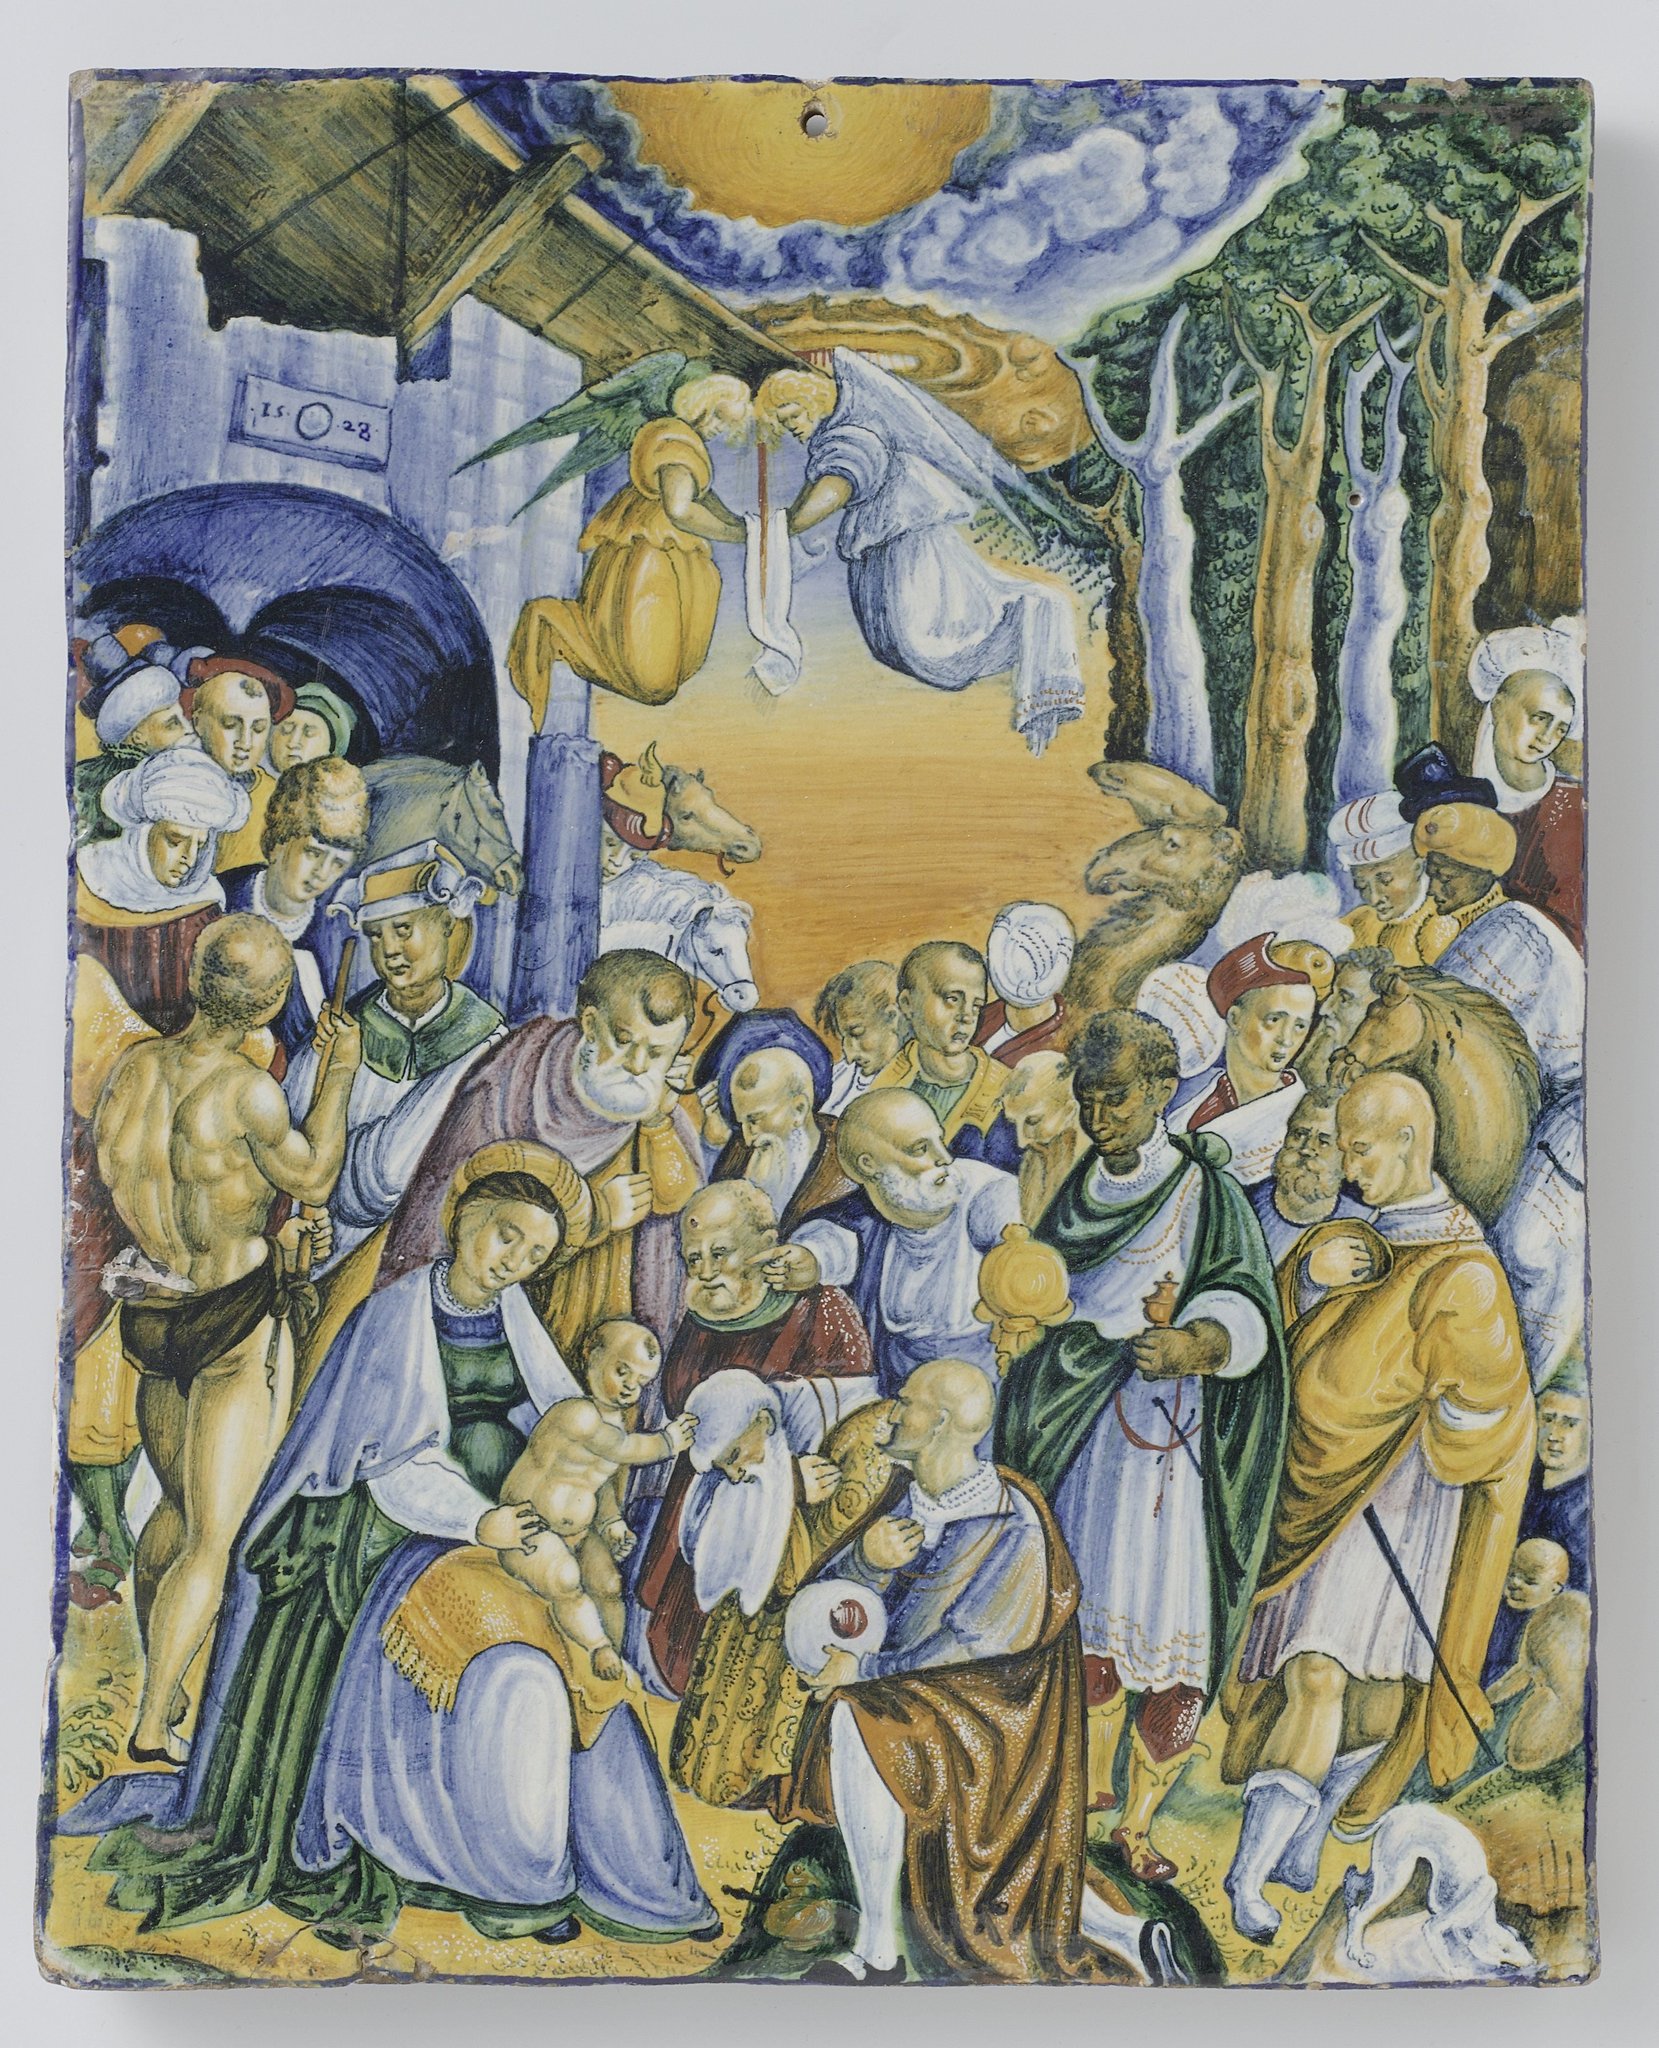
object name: plate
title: Plaat met de aanbidding van Jezus door de Wijzen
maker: piero bergantini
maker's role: draughtsman, painter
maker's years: 1503-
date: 1528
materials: earthenware, glaze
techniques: maiolica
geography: faenza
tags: adoration of the kings: the wise men present their gifts to the christ-child (gold, frankincense and myrrh)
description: Large tile plaque with the Adoration of the Magi. Maiolica. Faenza, workshop of Piero Bergantini (?), dated 1528.